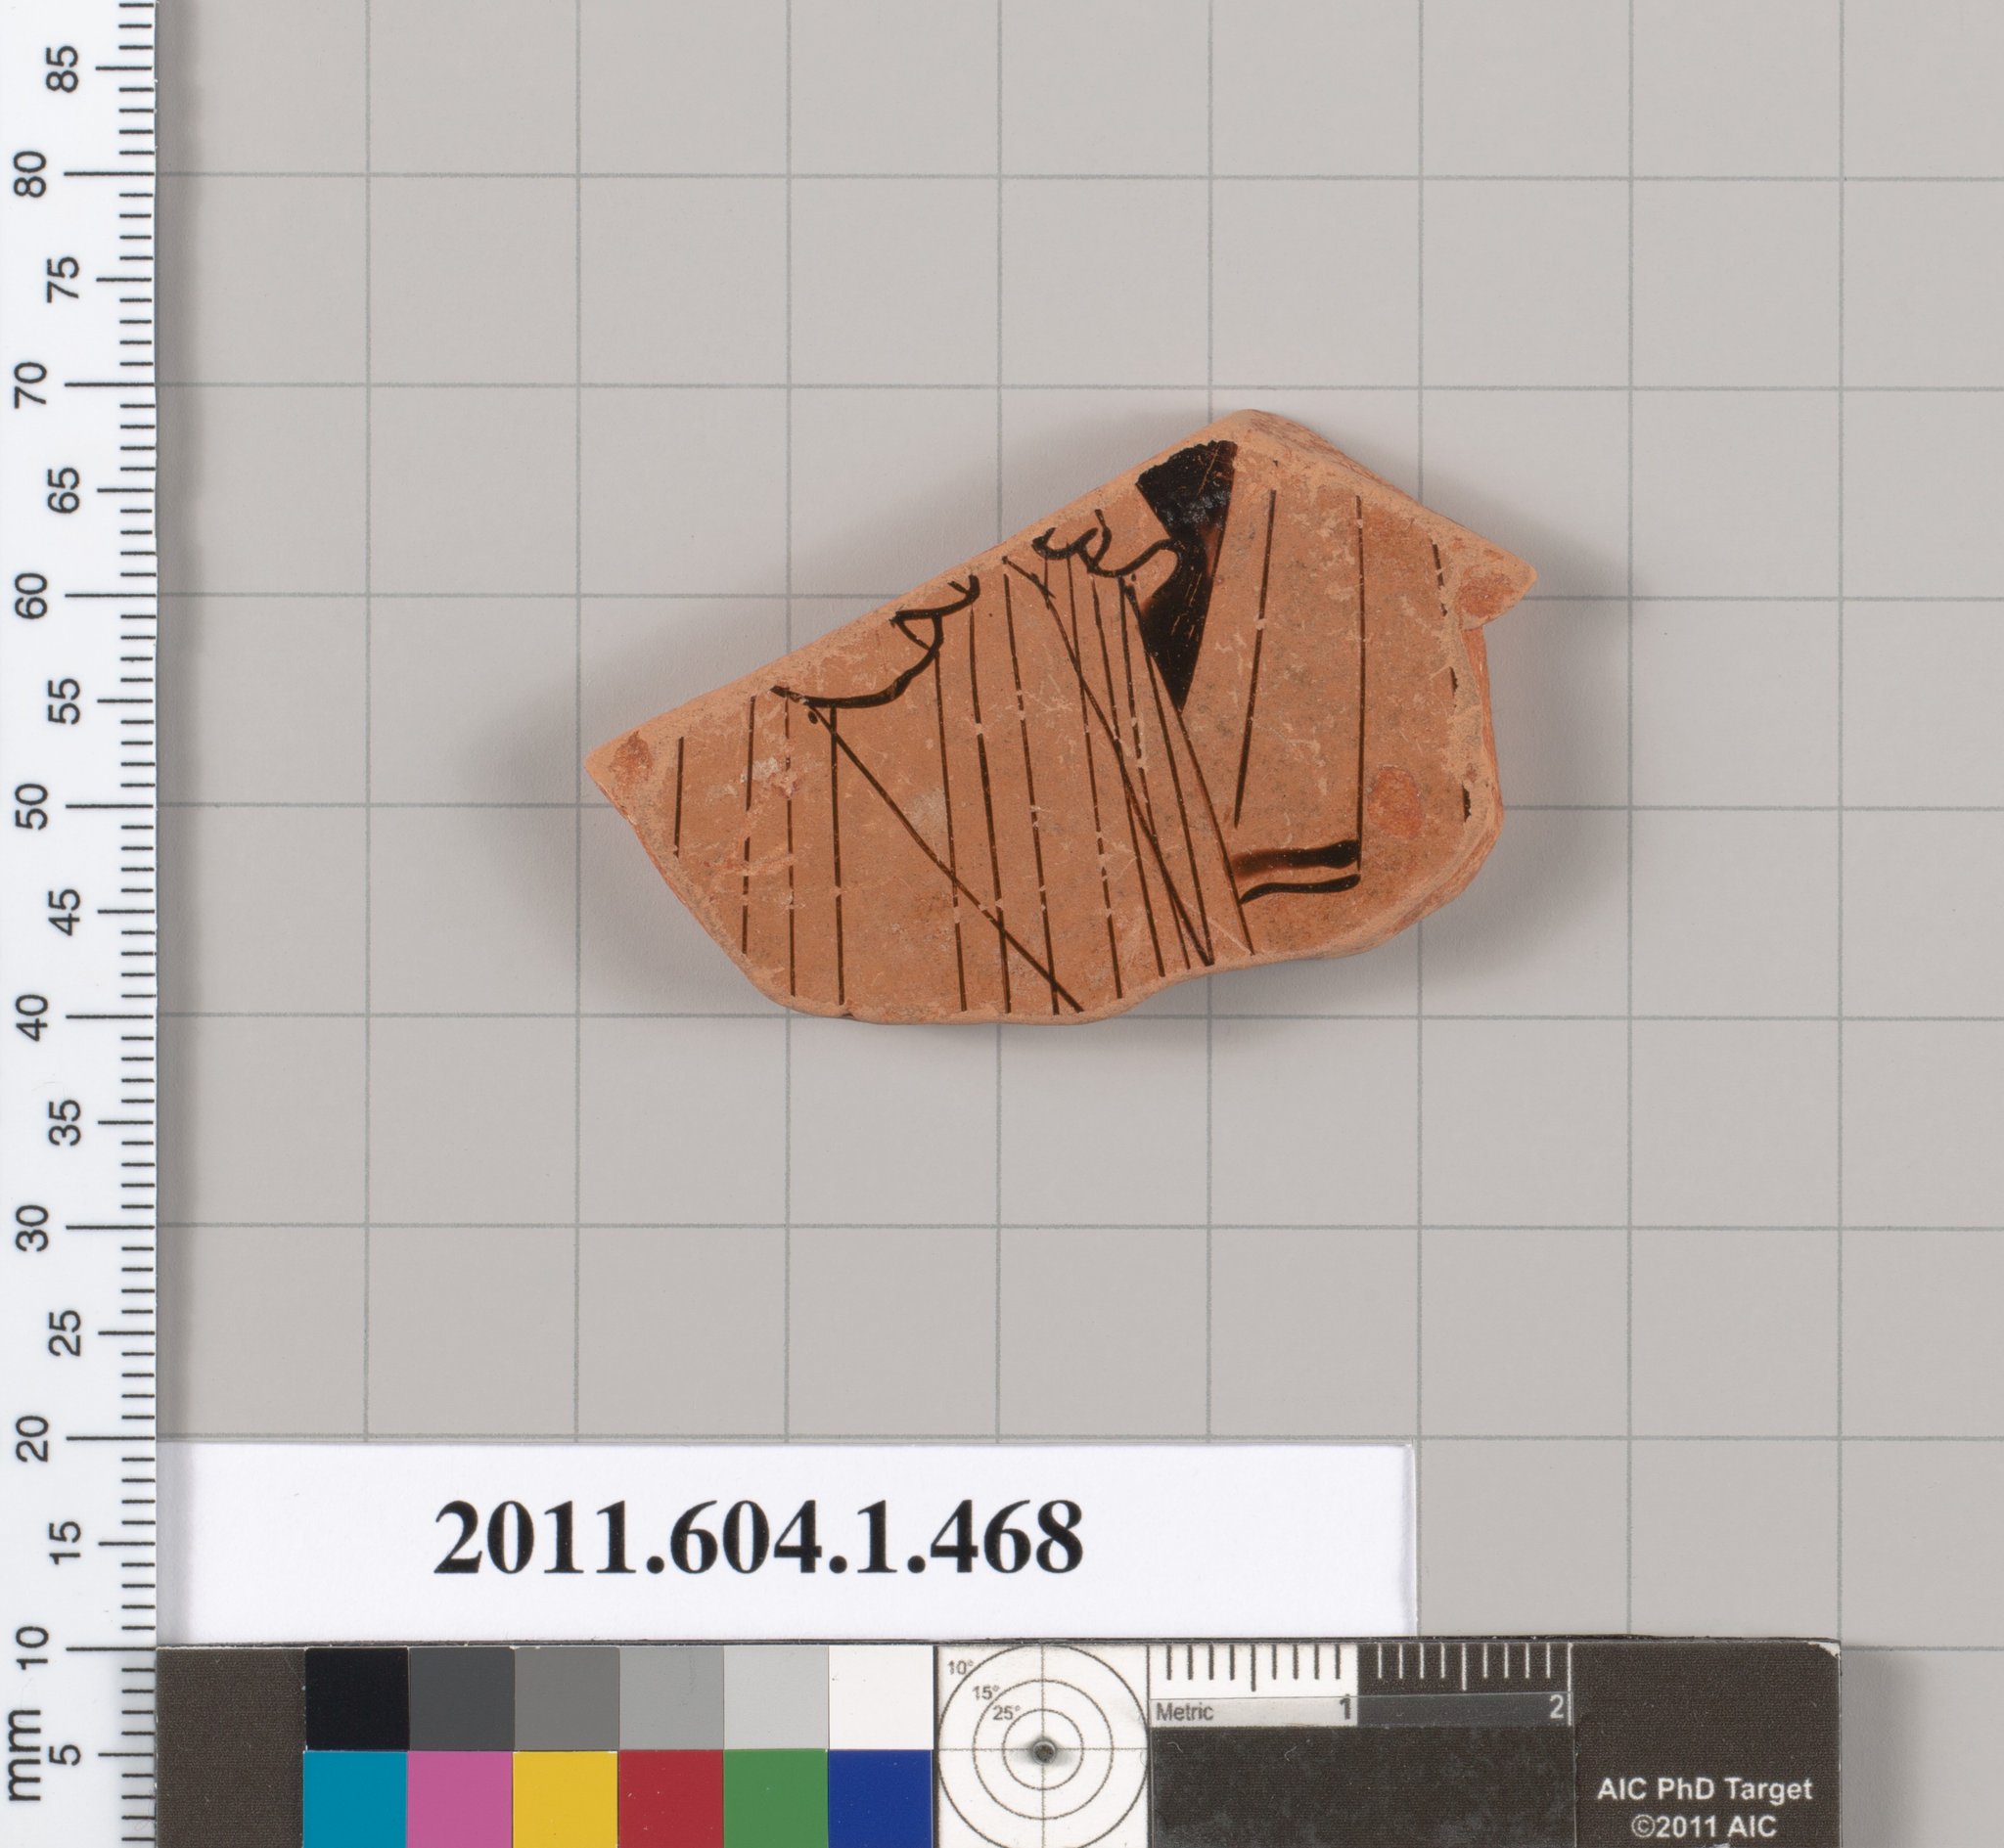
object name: kylix fragment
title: Terracotta fragment of a kylix (drinking cup)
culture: greek, attic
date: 490-480 BCE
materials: terracotta